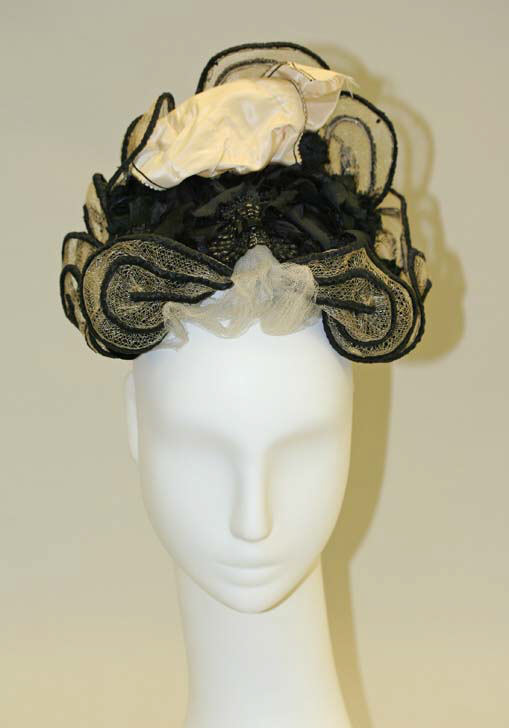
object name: hat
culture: american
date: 1893-1895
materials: hair, silk